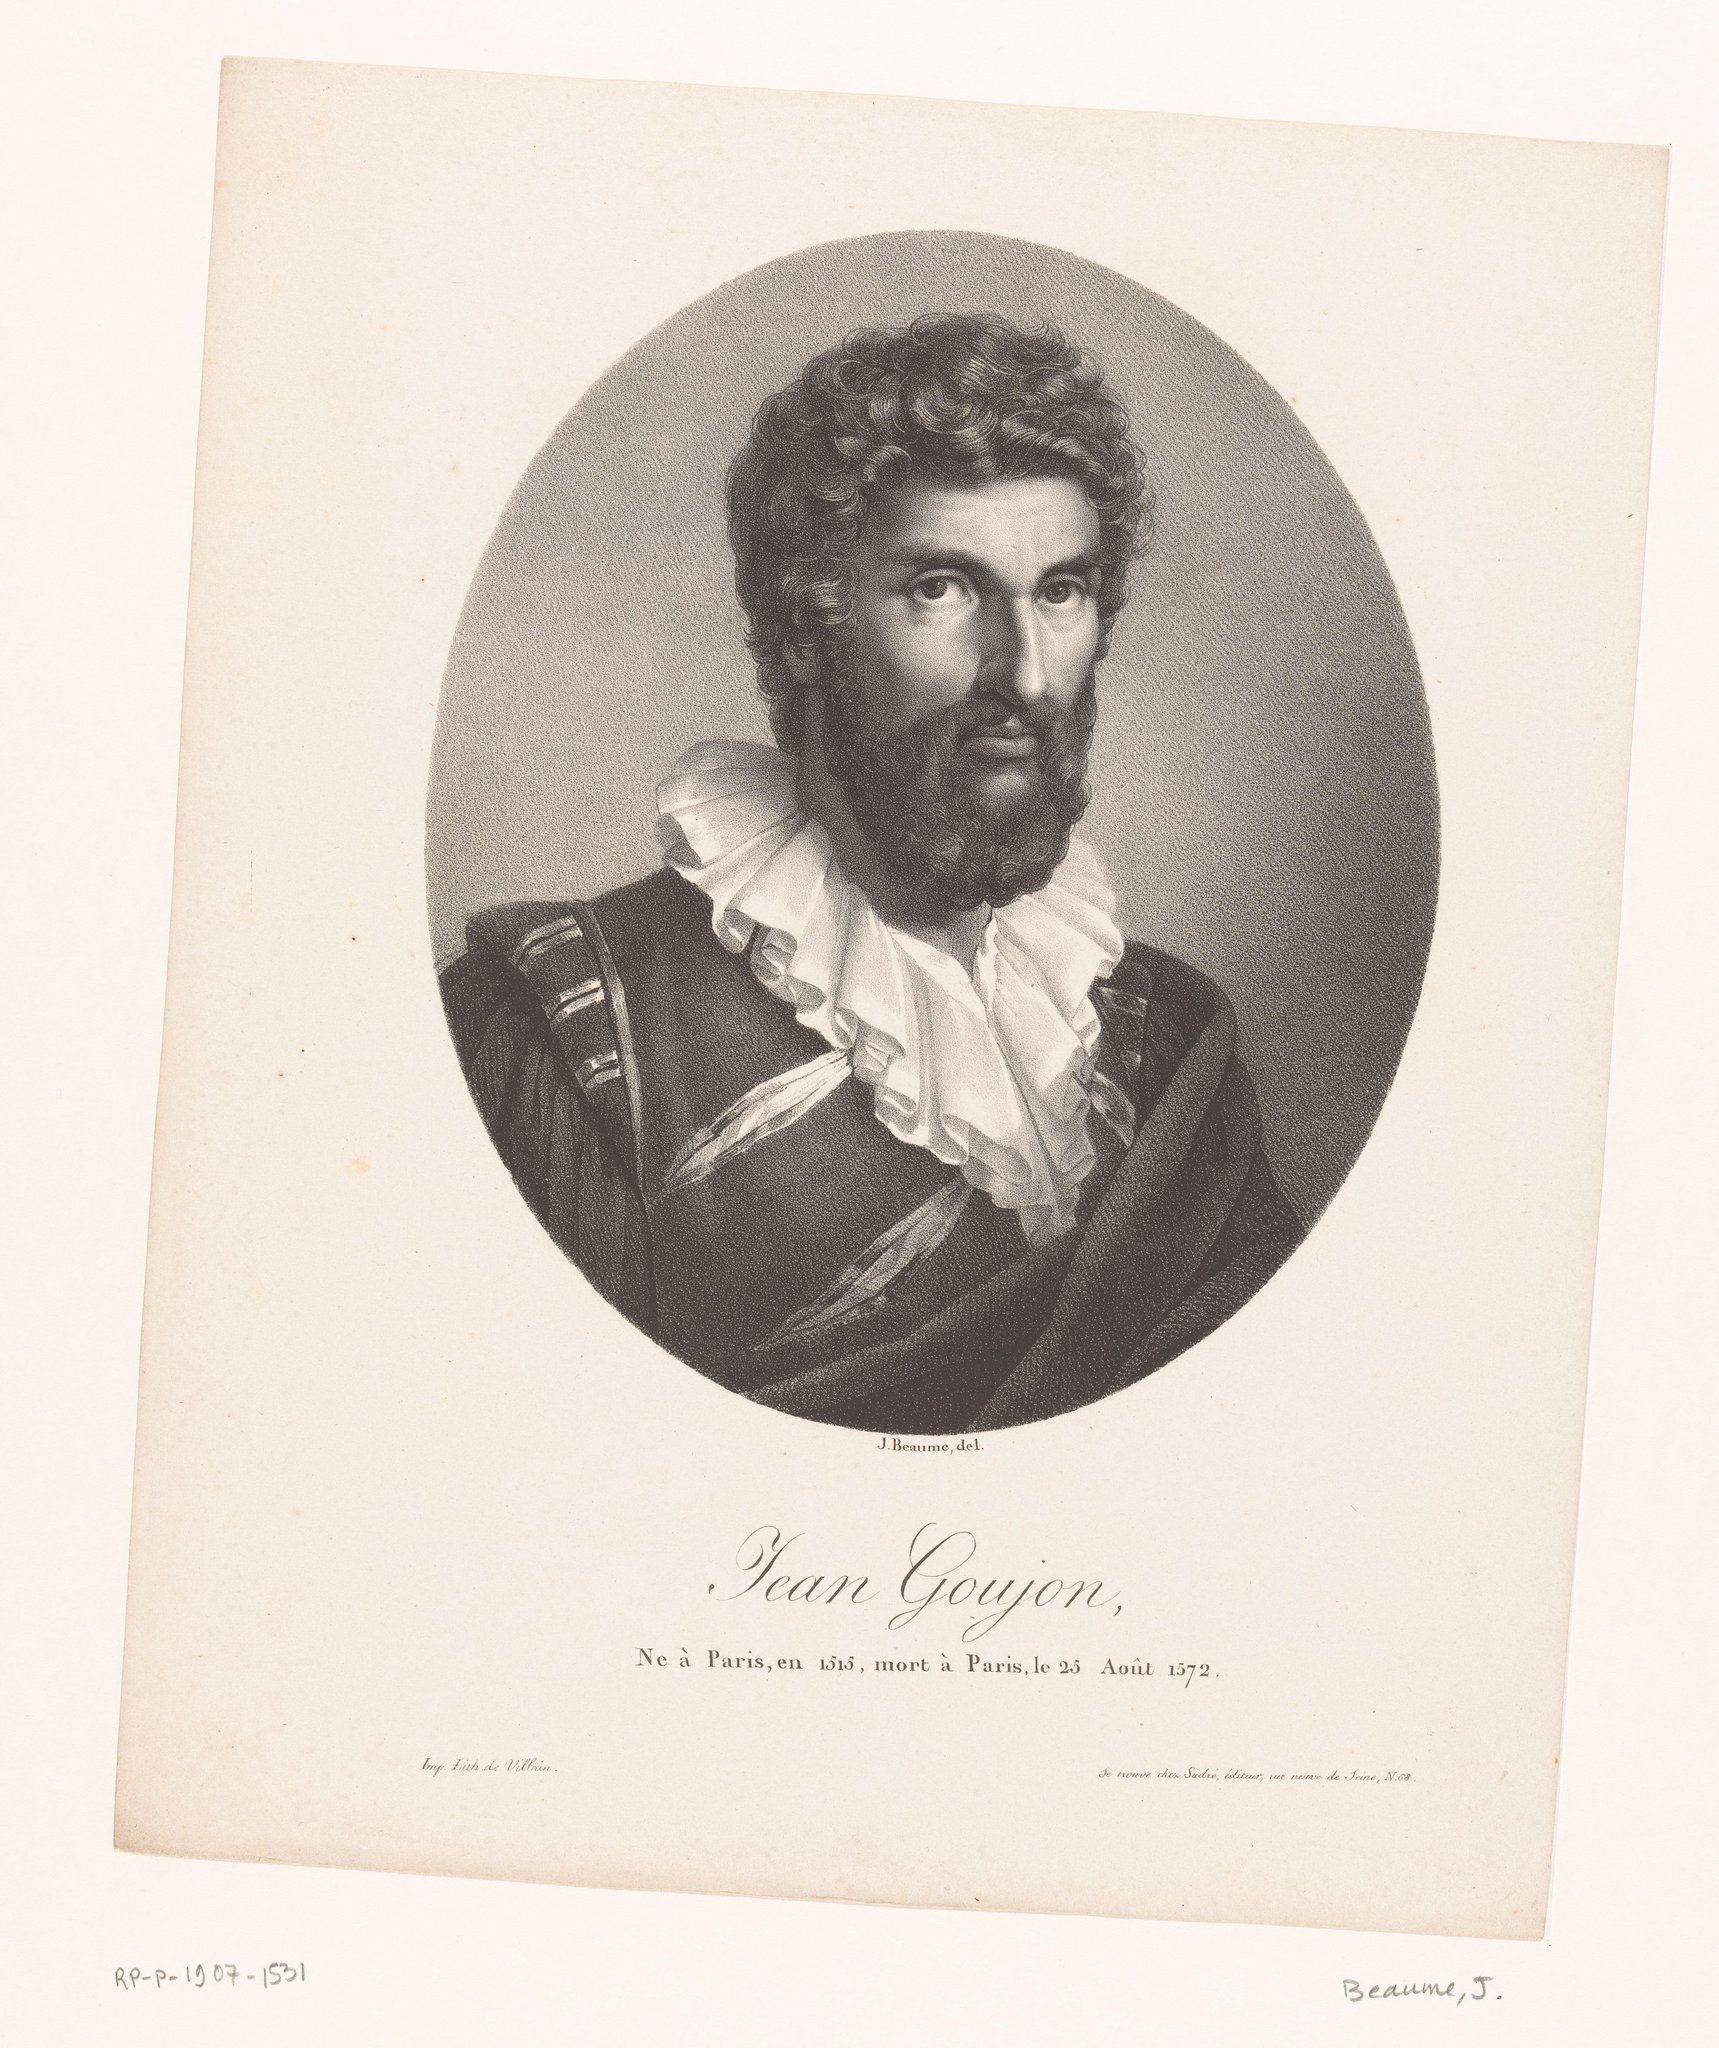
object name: print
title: Le panthéon français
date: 1823-1827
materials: paper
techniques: lithograph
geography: paris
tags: print maker, draughtsman, sculptor, jean goujon, historical persons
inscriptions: collector's mark: Lugt 2228a, annotation: ‘Sculpteur, un des restaurateurs des Arts en France’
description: De serie is in verschillende livrasons uitgegeven door Pierre Sudré tussen 1823 en 1827.